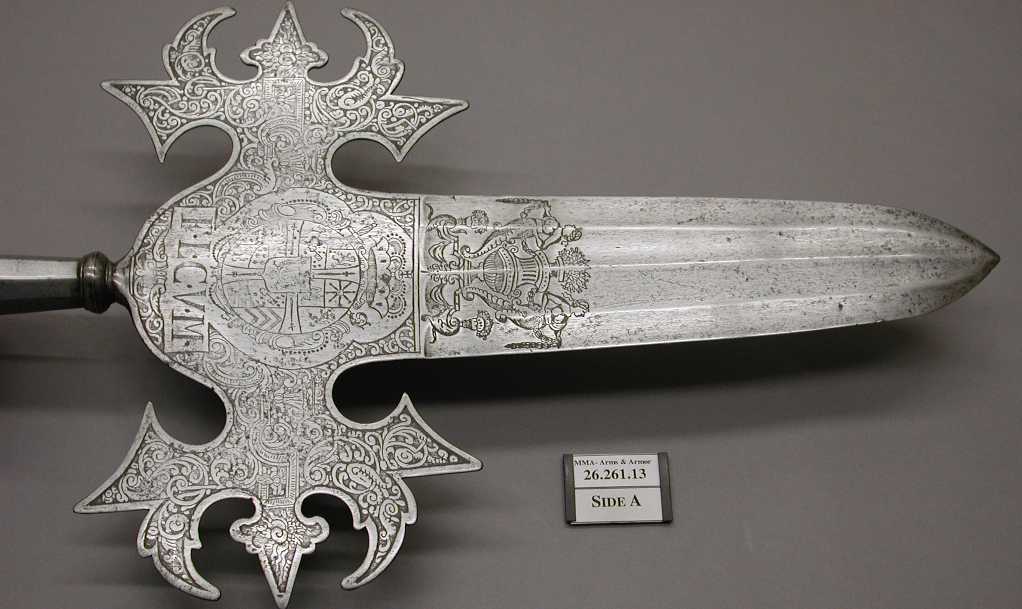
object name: partisan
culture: german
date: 1729-1732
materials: steel, textile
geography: germany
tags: coat of arms